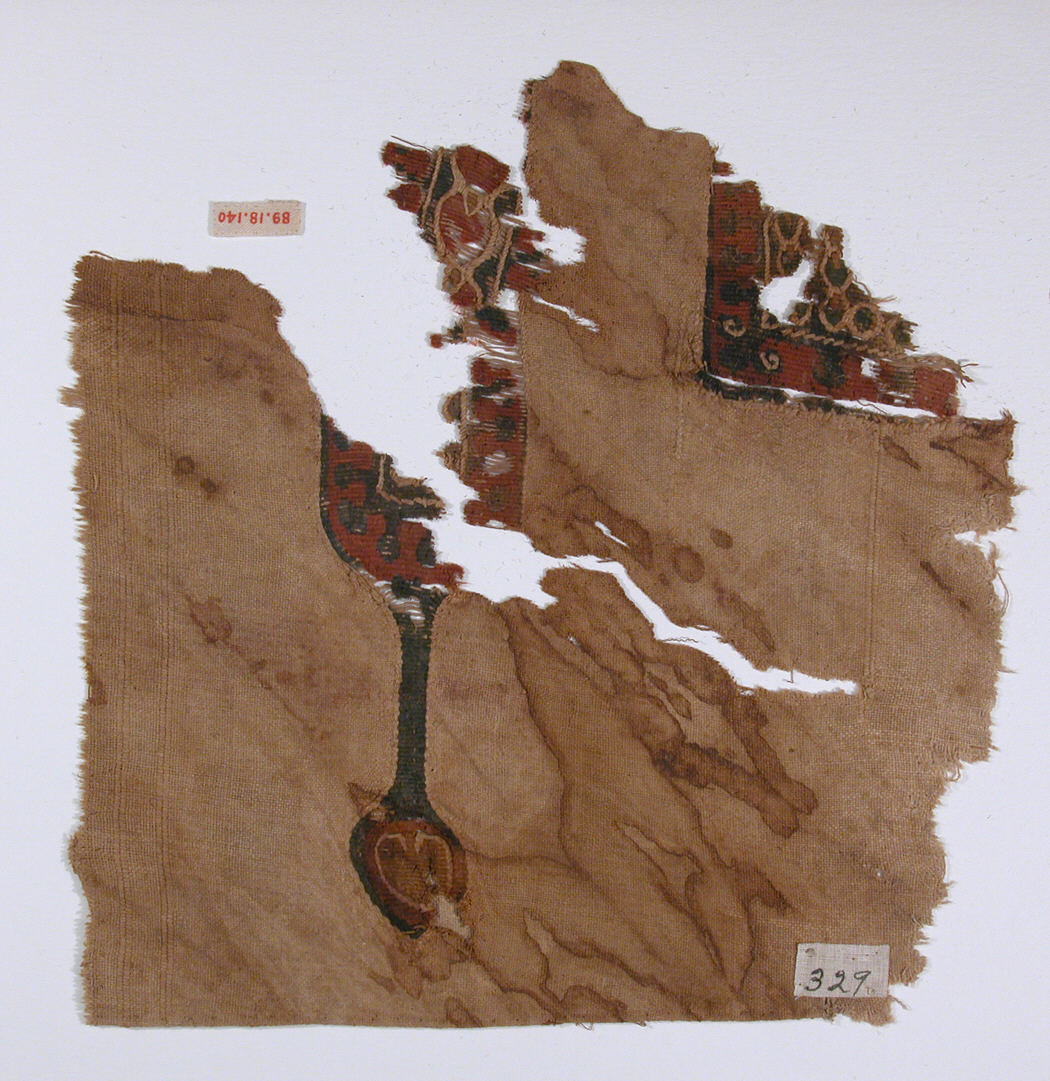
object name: textile fragment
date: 401-600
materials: linen, wool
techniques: weave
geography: egypt